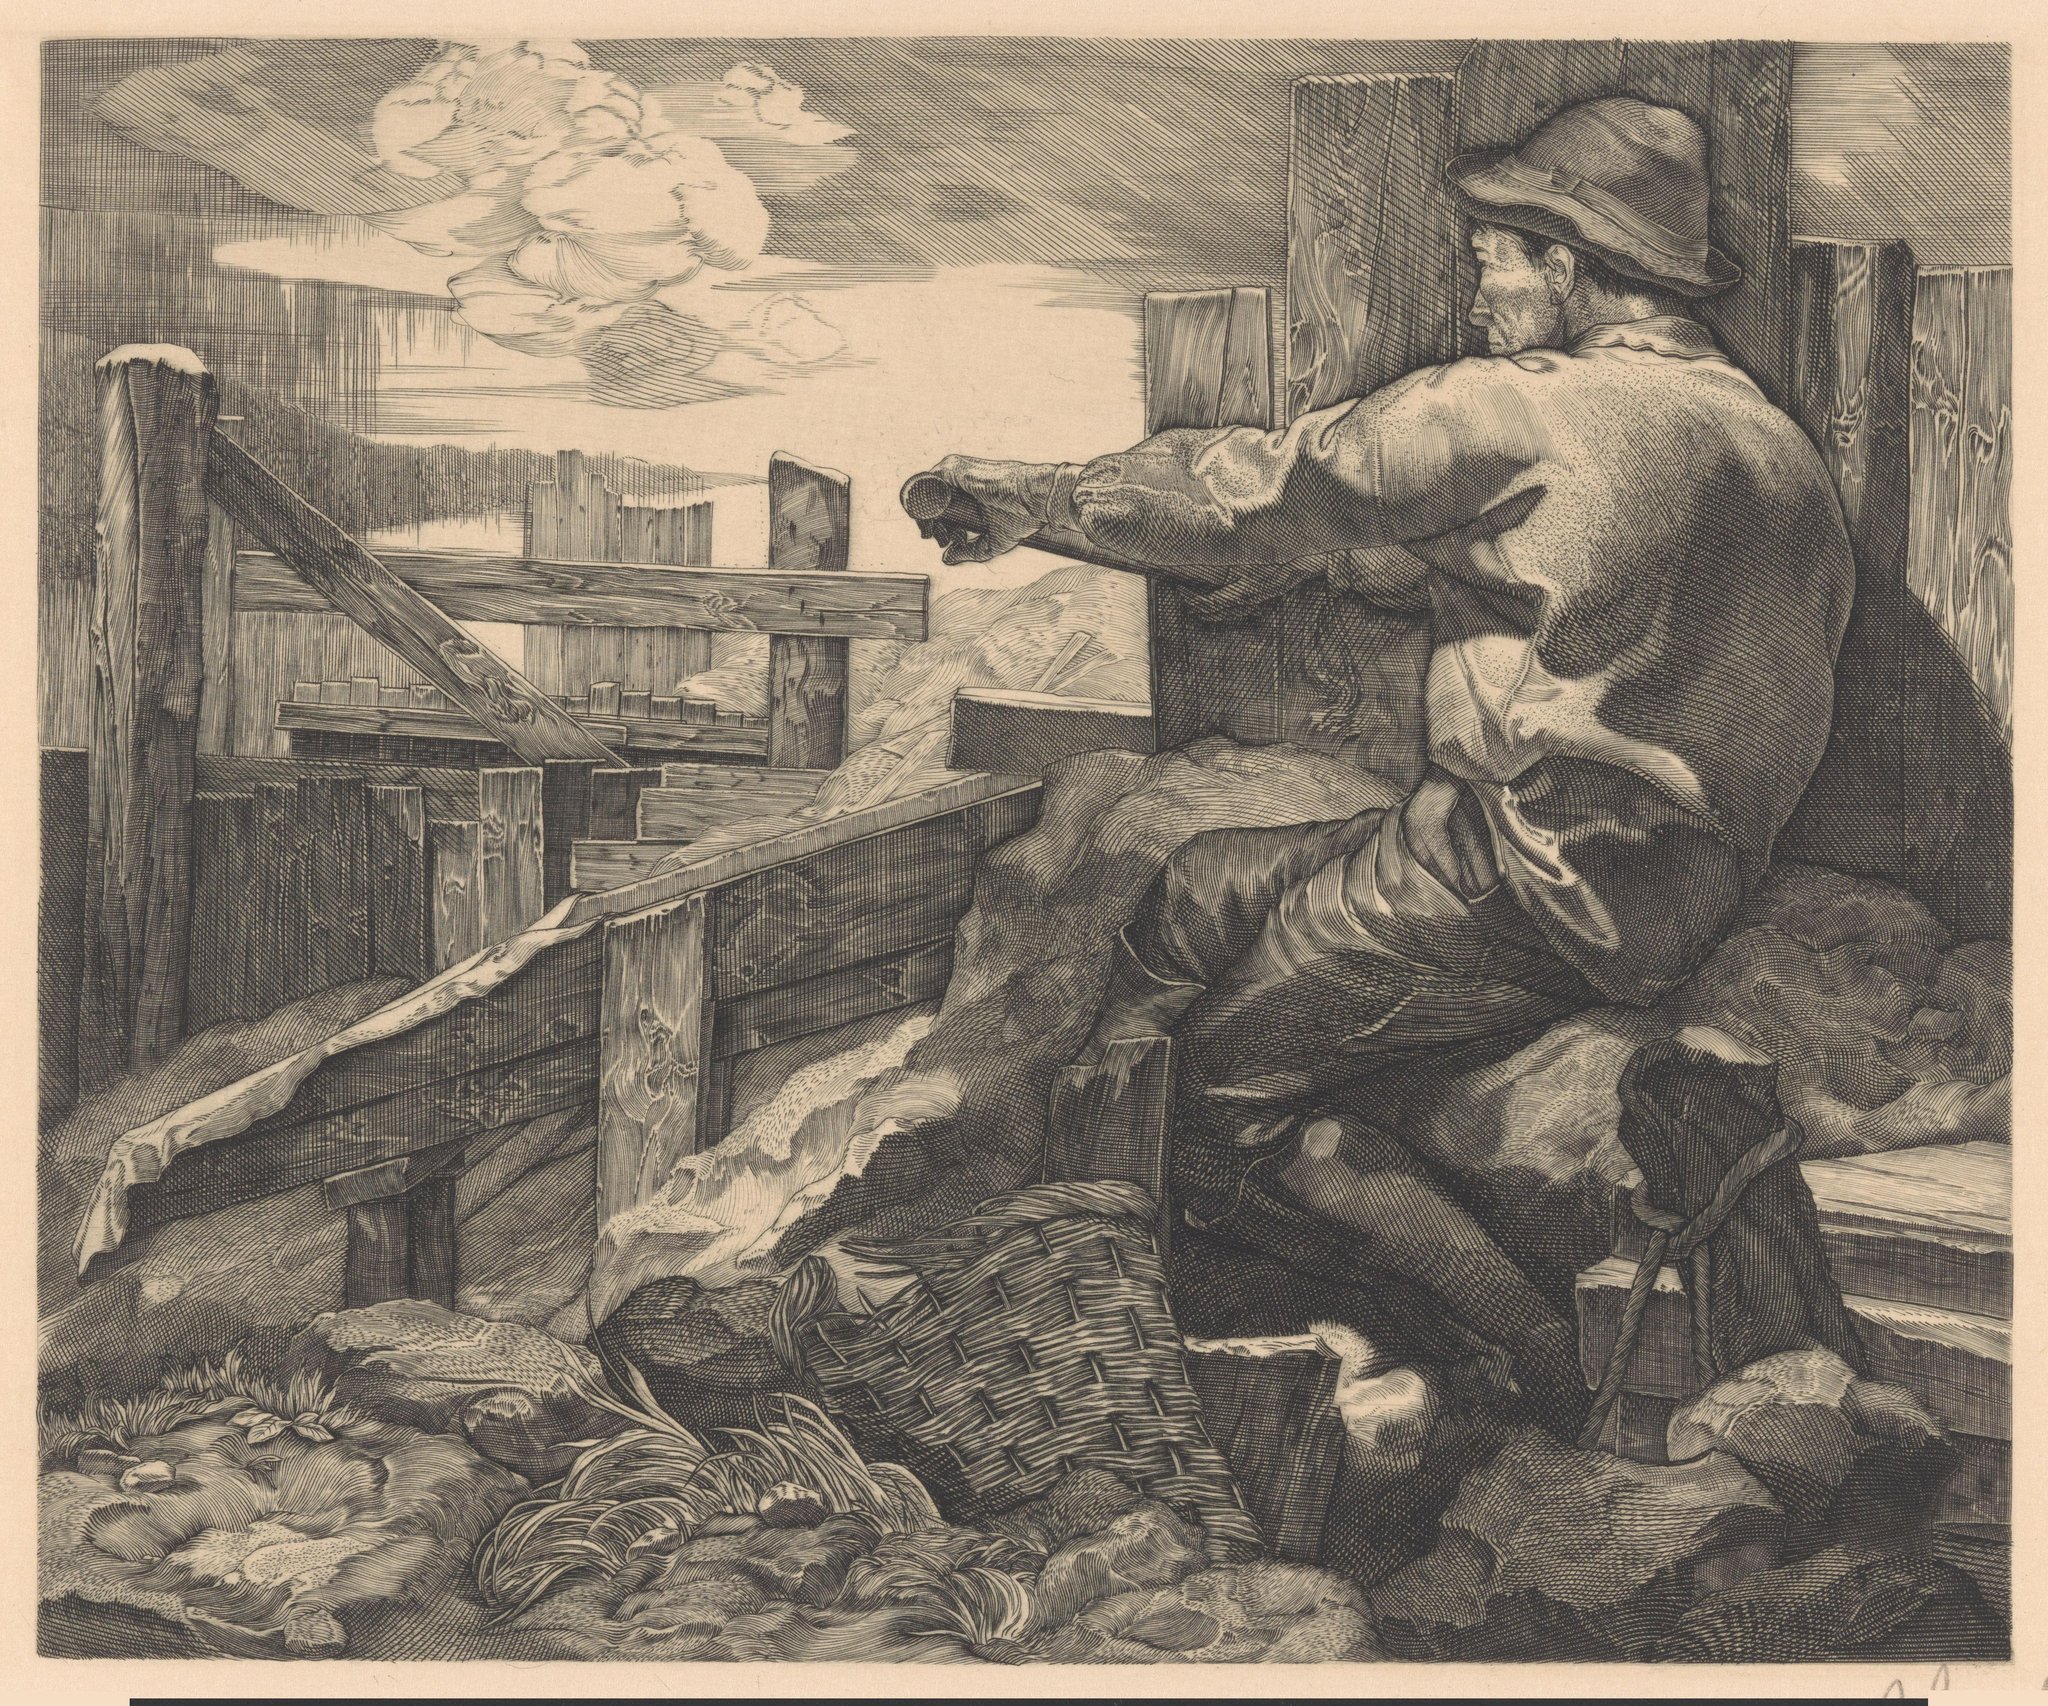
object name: print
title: Wrikkende arbeider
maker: johannes josephus aarts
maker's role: draughtsman, print maker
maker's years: 1871-1934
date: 1881-1931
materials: paper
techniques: engraving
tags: working class, labourers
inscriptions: collector's mark: Lugt 2228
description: Een arbeider wrikt met een staaf tussen een stel balken. Op de voorgrond een rieten mand.